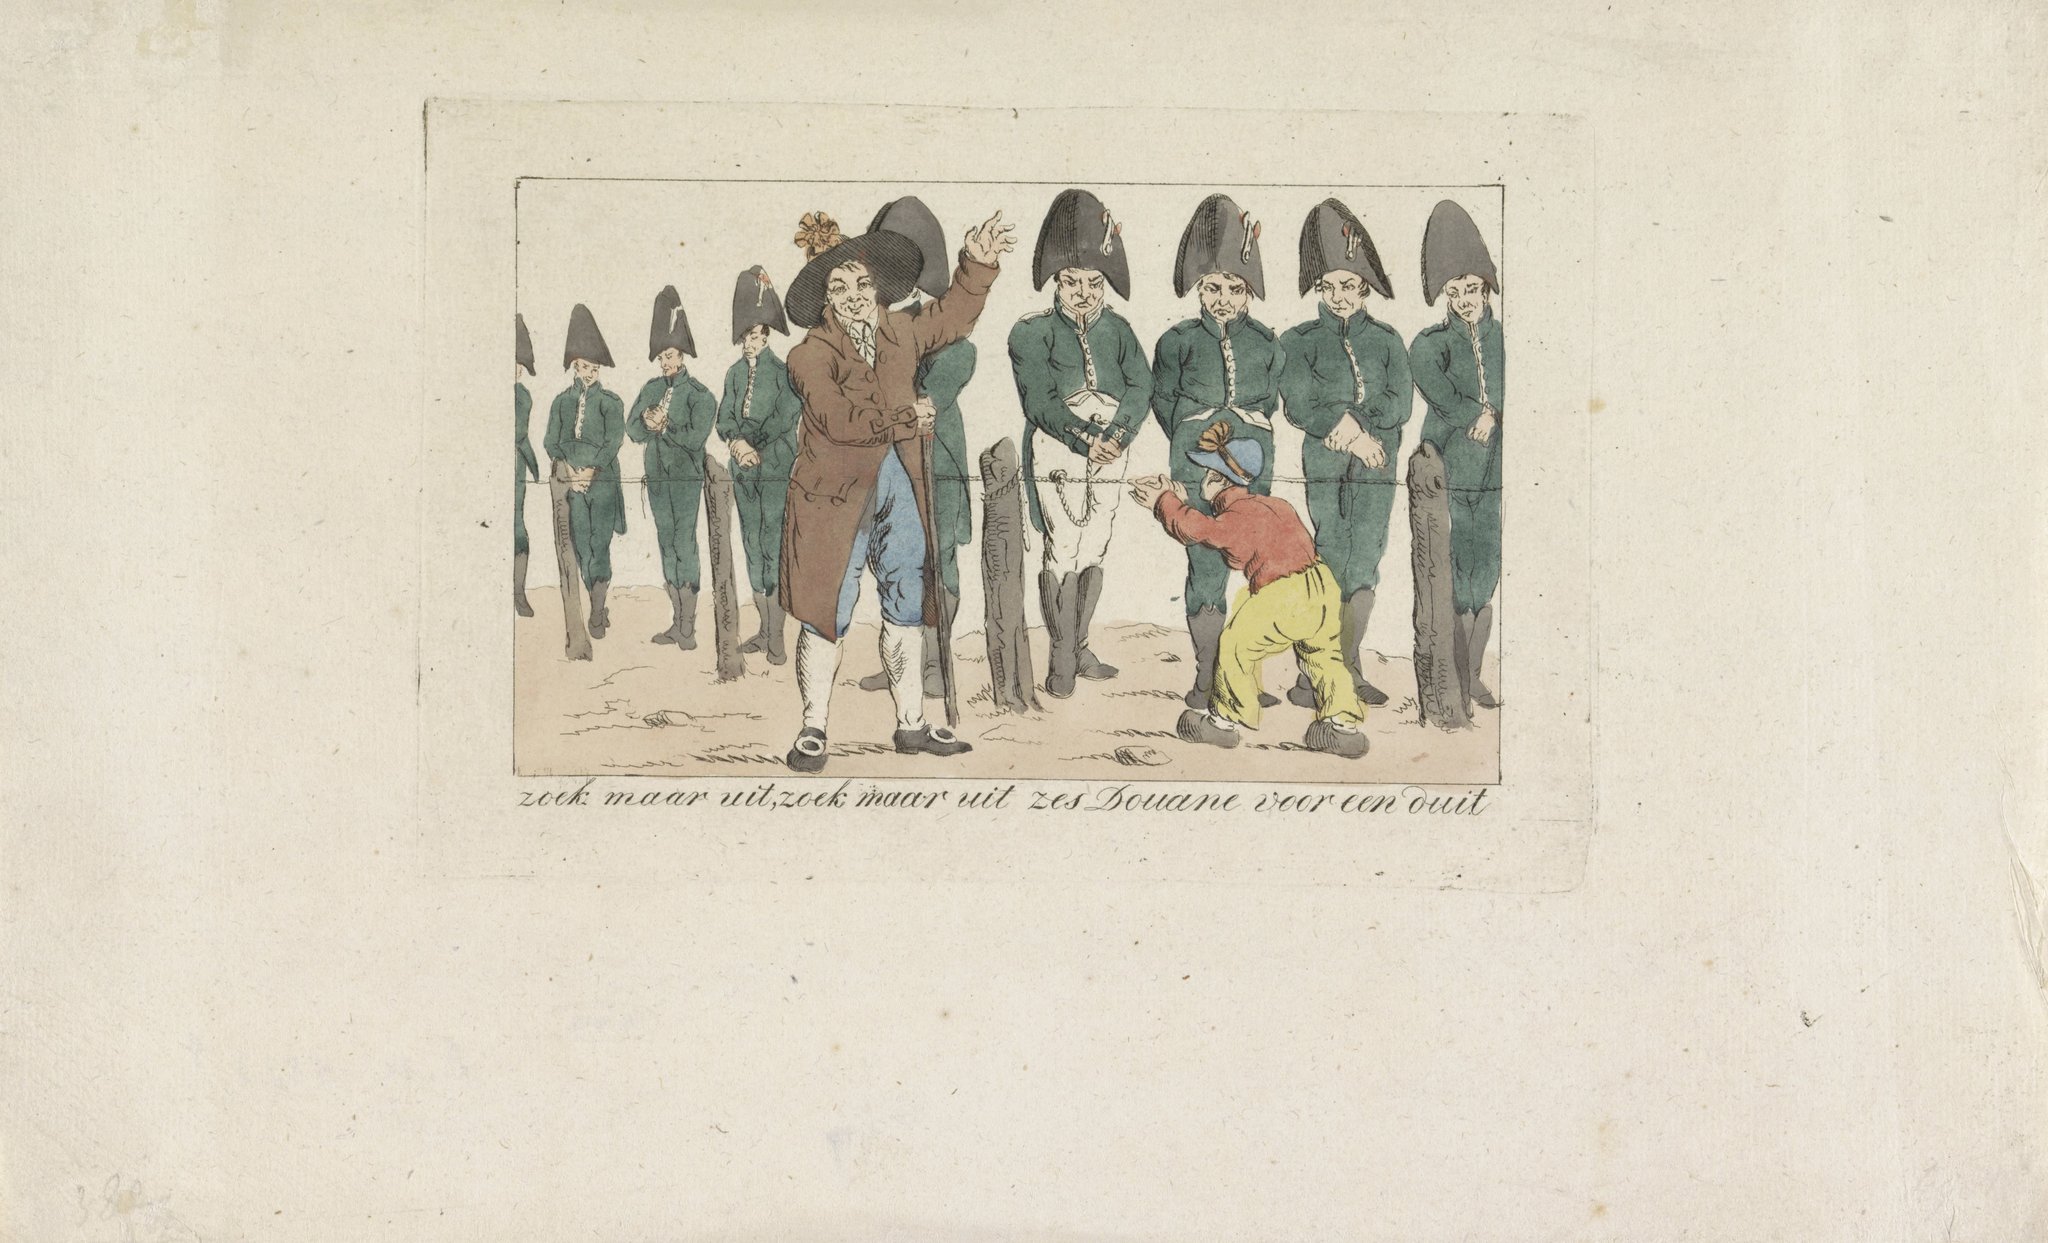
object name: print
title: Zoek maar uit, zoek maar uit zes Douane voor een duit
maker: jacob smies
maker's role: draughtsman, painter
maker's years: 1746-1833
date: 1813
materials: paper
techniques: engraving, etching, hand coloring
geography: netherlands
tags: amsterdam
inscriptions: collector's mark: Lugt 2228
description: Een veehandelaar met oranje kokarde versierd verkoopt Franse douaniers als waren ze vee. De douaniers staan achter een afzetting te wachten, een kleine jongen bespot ze. Er ontstonden op 15 november 1813 rellen in Amsterdam na het nieuws van de nederlaag van Napoleon bij Leipzig.